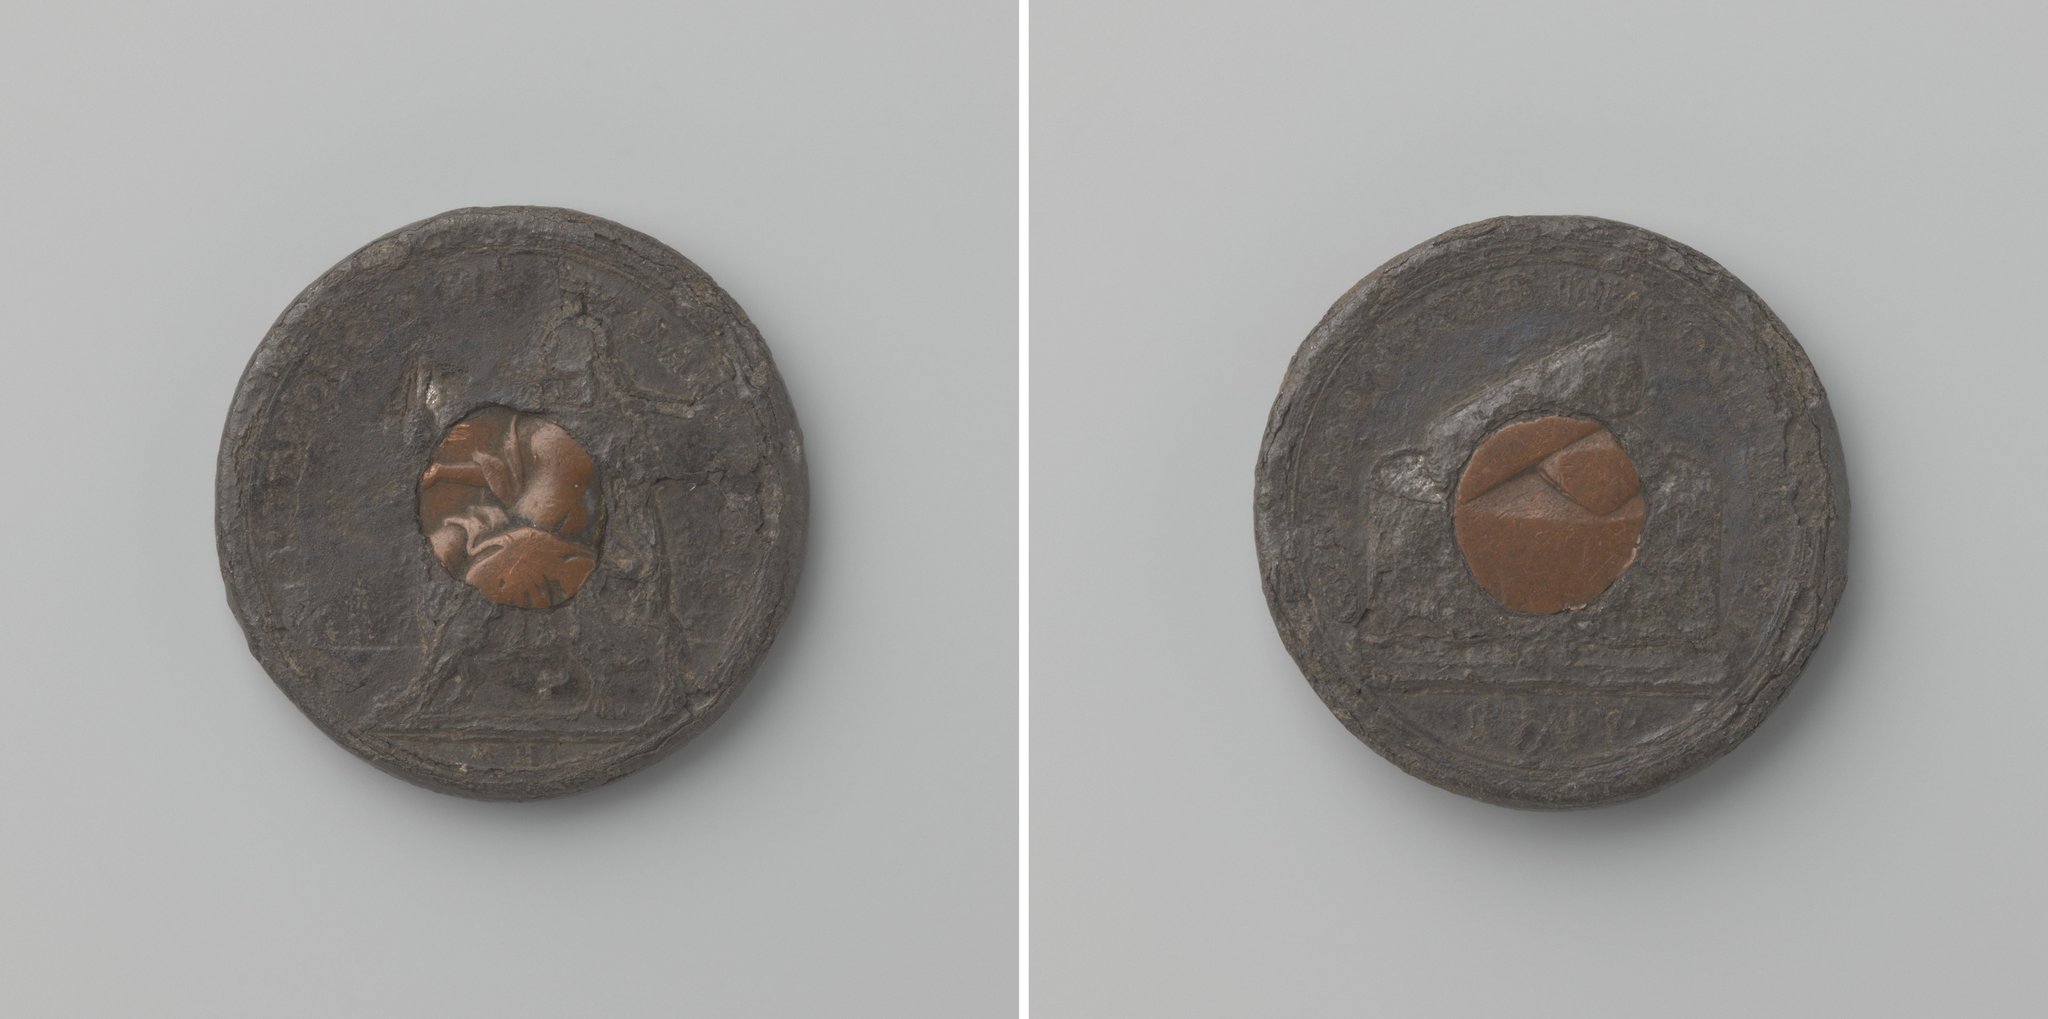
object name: loden penning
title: Broodpenning van de Gereformeerde Diaconie te Amsterdam 1777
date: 1777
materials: copper, tin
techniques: striking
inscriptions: circumscription: ‘GEREFORMEERD DIACONIE BROOD’, circumscription: ‘VERGENOEGD EN DANKBAAR’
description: Tinnen penning met smalle koperen plug, op de voorzijde een vrouw zittend naast een schaap, een duif op haar hoofd en een juk om haar nek, met omschrift, op de keerzijde twee broden op een beklede tafel, met omschrift, in afsnede 1777, op de voorzijde ingestempeld B en A